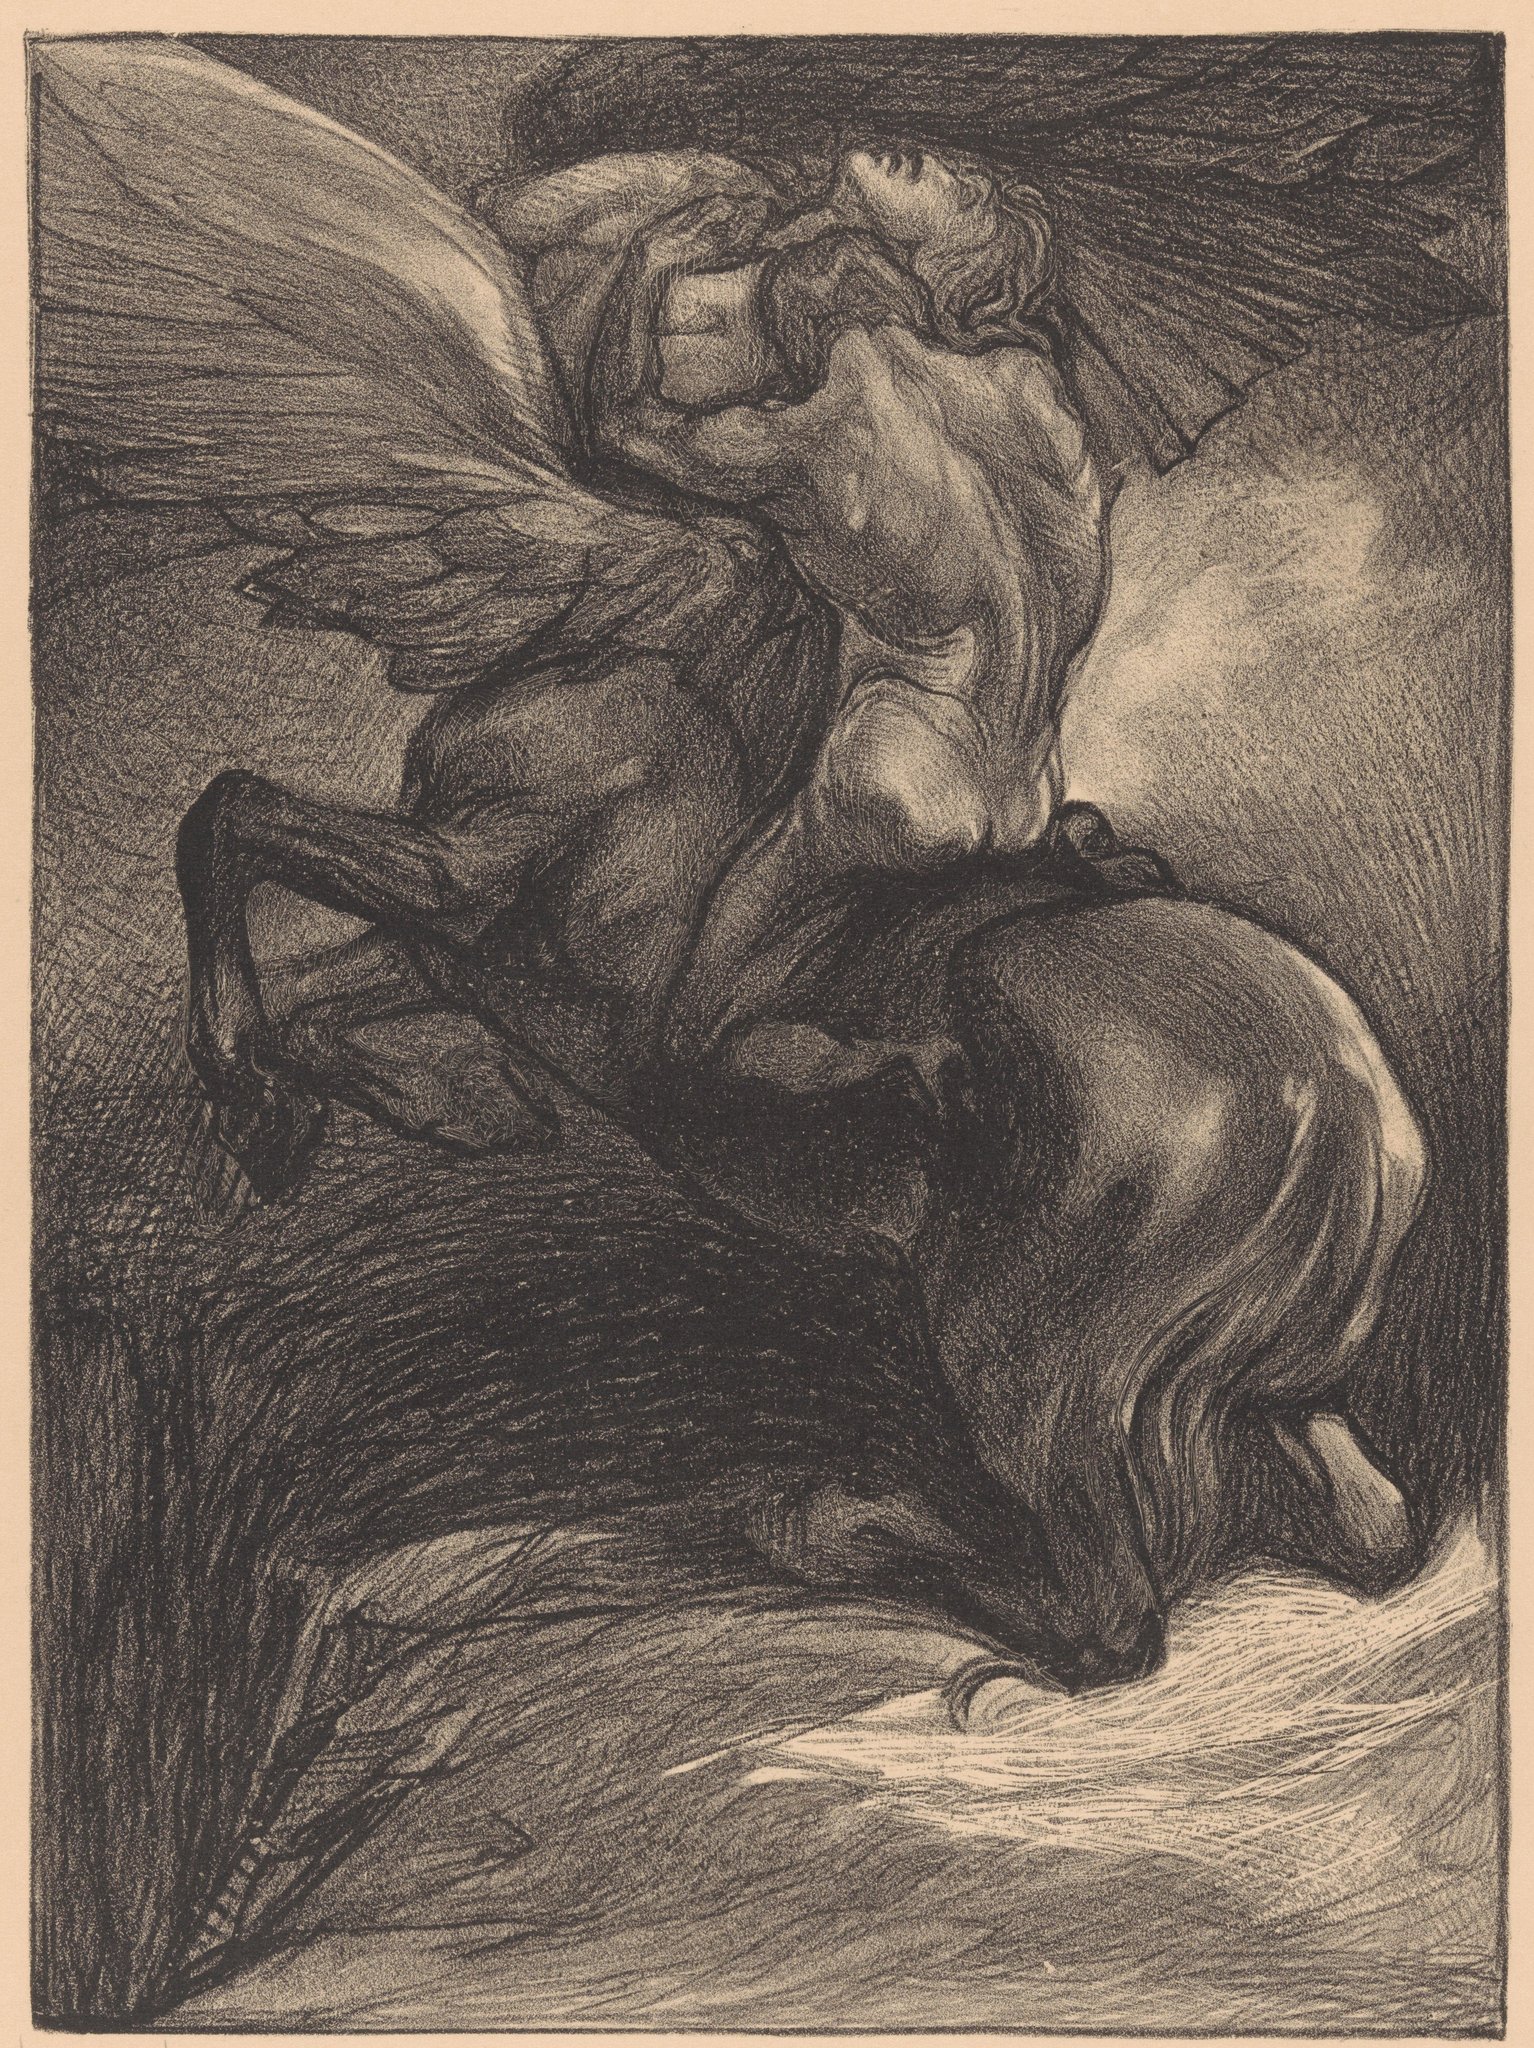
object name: print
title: Bellerophon, Pegasus en de gedode Chimaera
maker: johannes josephus aarts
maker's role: draughtsman, print maker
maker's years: 1871-1934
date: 1927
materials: paper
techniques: lithograph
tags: bellerophon, flying on pegasus' back, kills the chimera, a fire-breathing monster, with arrows or a spear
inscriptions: collector's mark: Lugt 2228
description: Bellerophon, gezeten op het vliegende paard Pegasus, met de door hem gedode Chimaera in zijn armen.